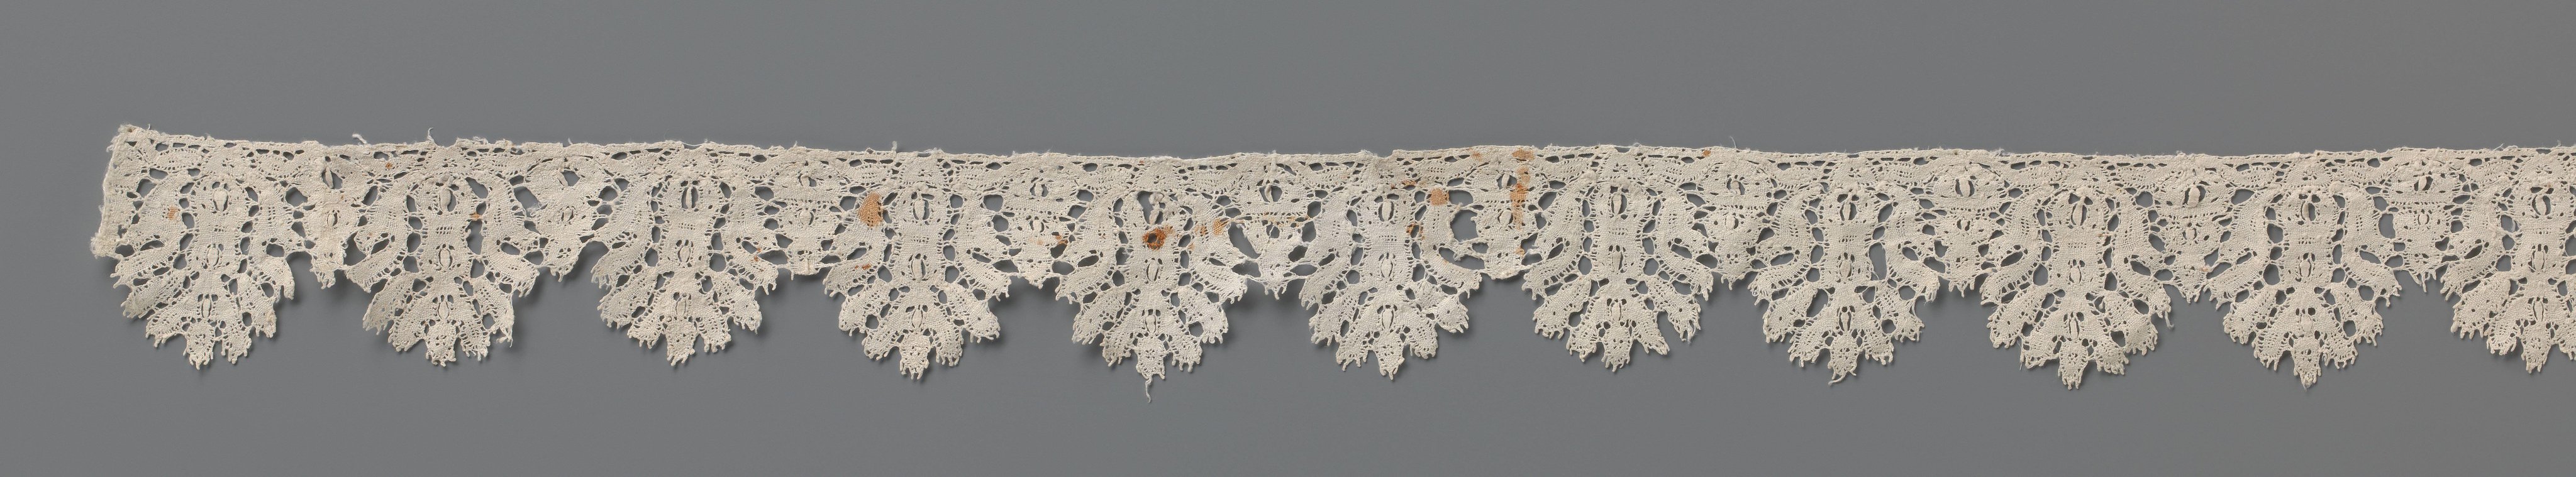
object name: strip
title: Strook kloskant met distel of korenbloem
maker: Anonymous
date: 1625-1649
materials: linen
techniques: lace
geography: southern netherlands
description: Strook naturelkleurige kloskant: oudvlaamse kant. Halfronde schulpen met grillige randen met in elke schulp een symmetrisch patroon met een naar beneden hangende bloem, mogelijk een distel of korenbloem. De motieven zijn gemaakt in linnenslag met opengewerkte randjes en uitsparingen. In de lengte-as zijn in uitsparingen bladvormige vormslagen toegepast. De motieven zijn met elkaar verbonden door korte overstekende paren, een grond ontbreekt. De bovenzijde van de strook is recht afgewerkt. De schulpenrand is afgewerkt met picots.